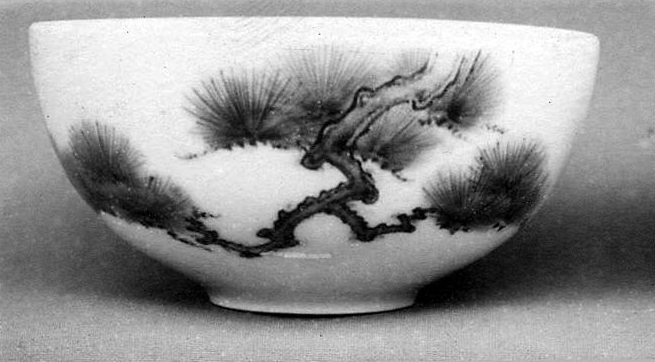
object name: bowl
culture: japanese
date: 1820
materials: glaze, porcelain